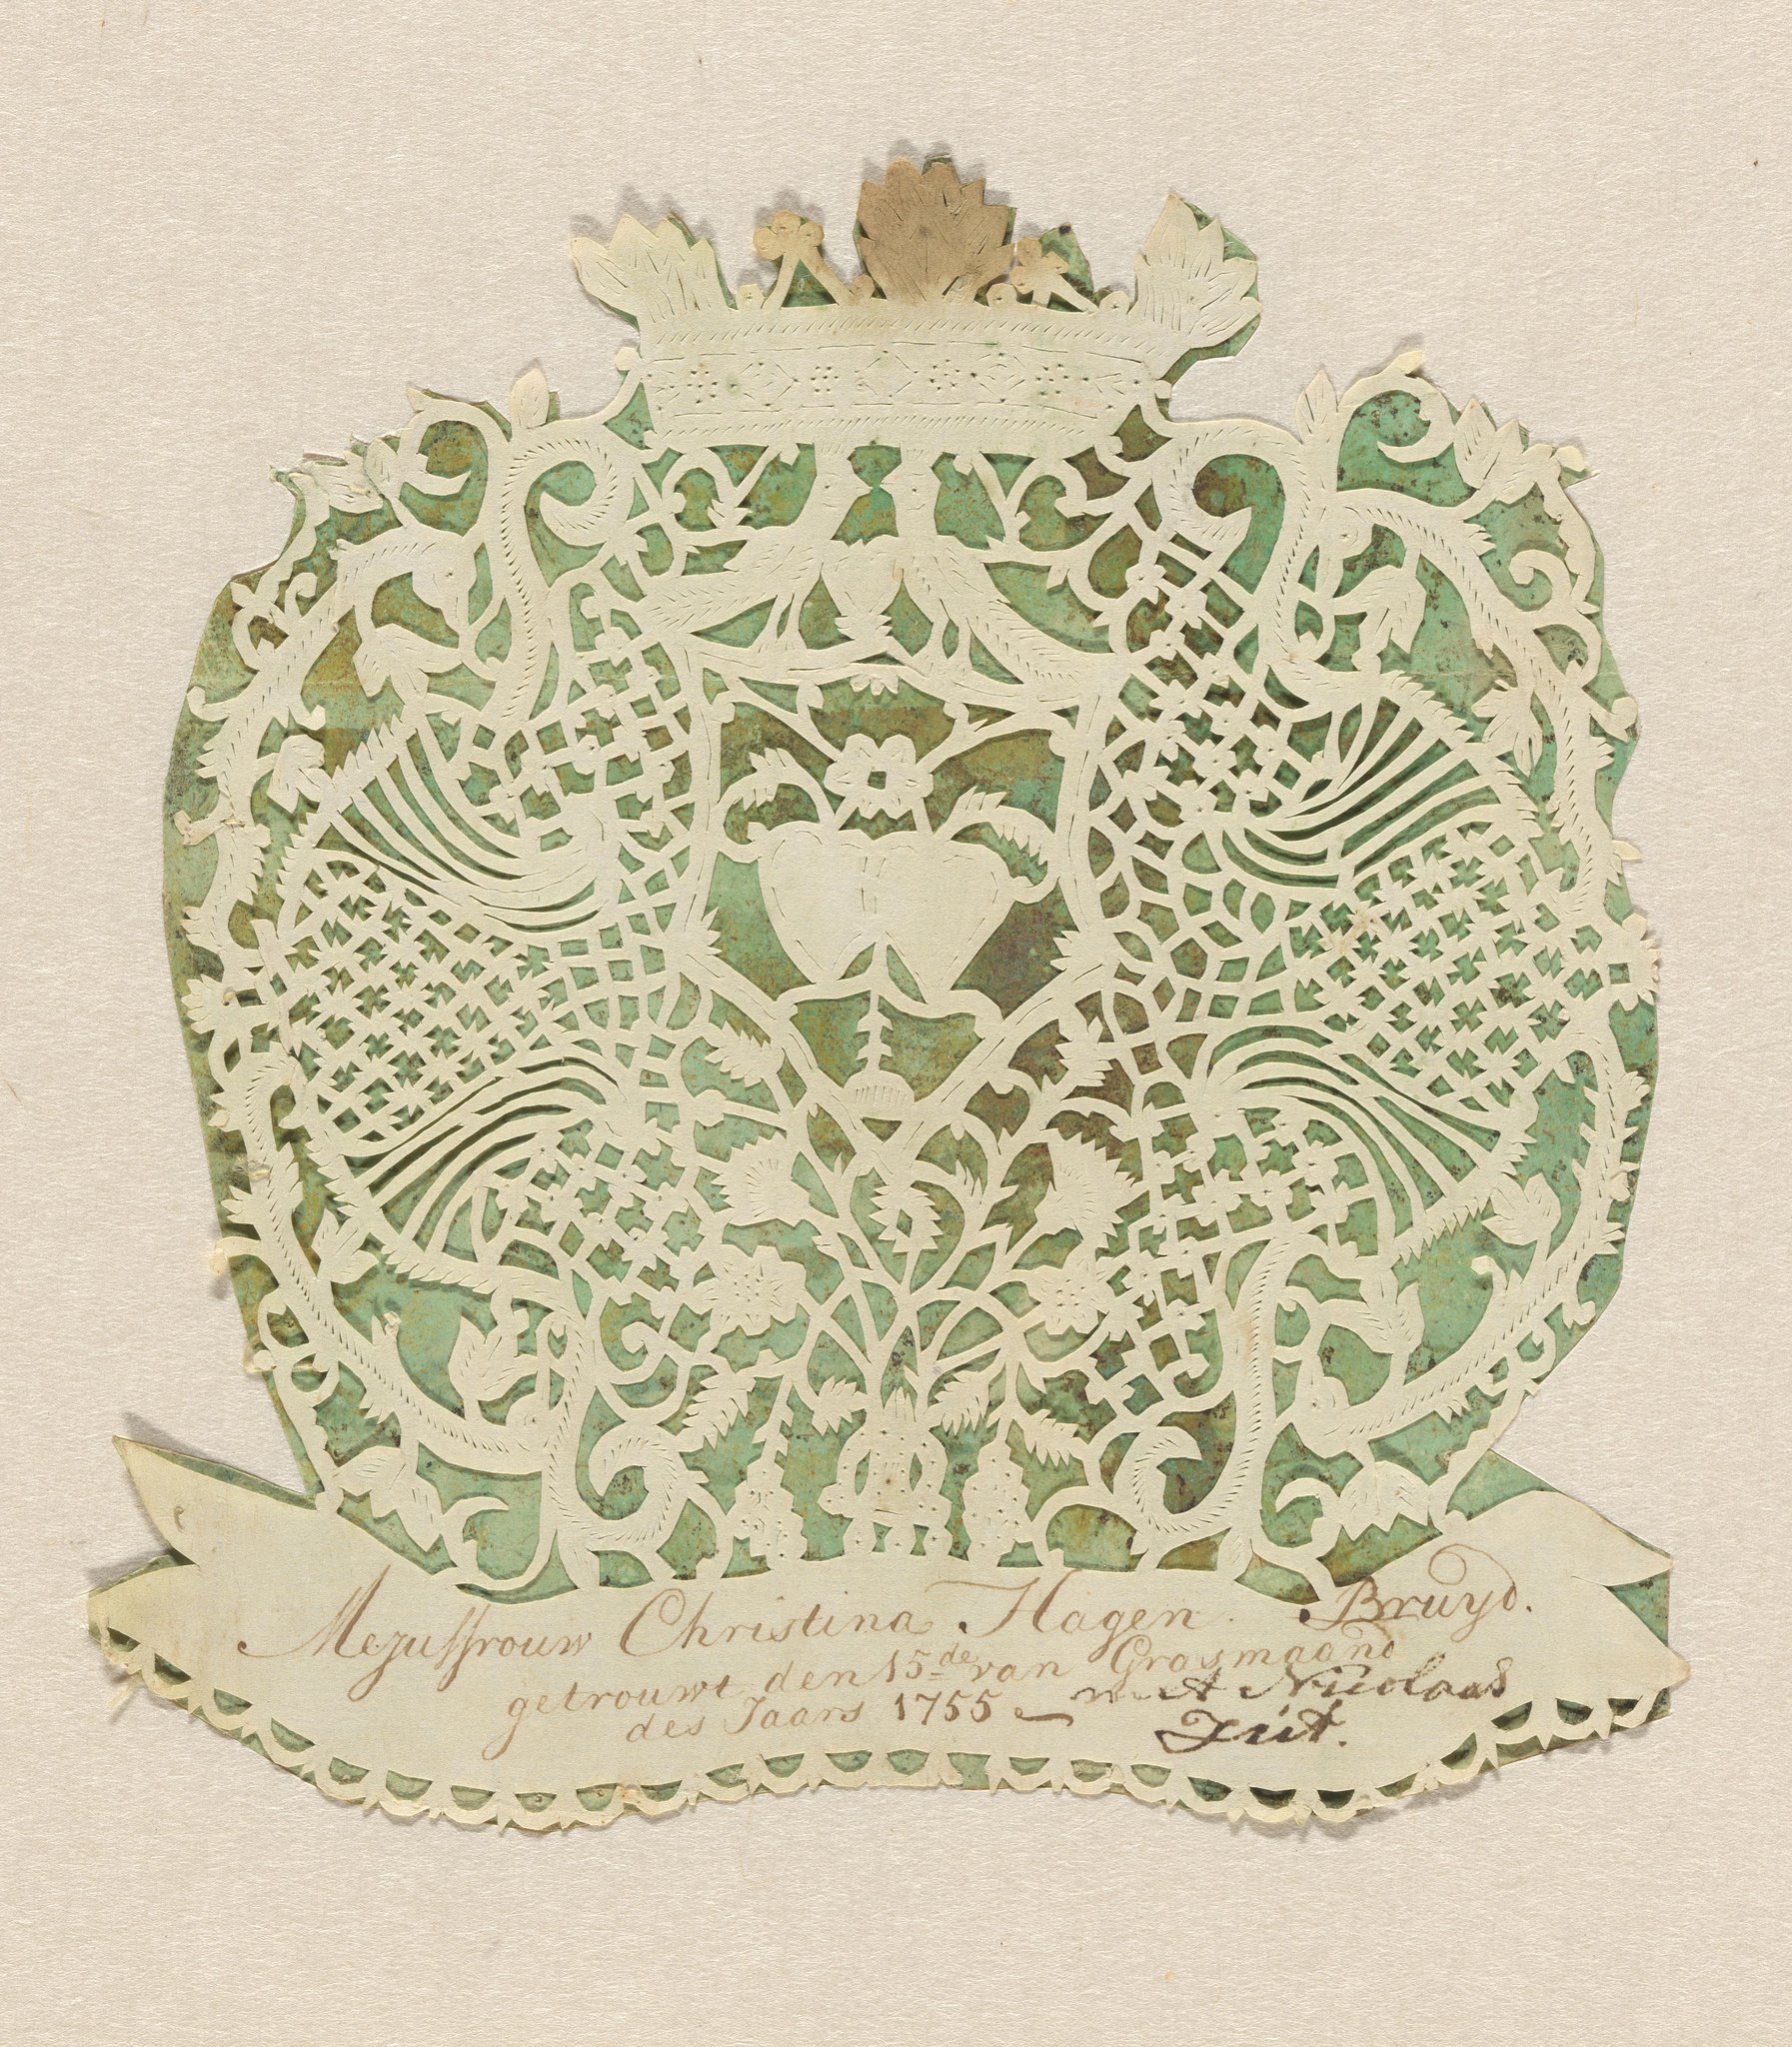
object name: cut paper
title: Huwelijksknipsel voor bruid Christina Hagen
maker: Anonymous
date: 1755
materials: paper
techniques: cutting, snipping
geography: netherlands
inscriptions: inscription: ‘ Mejuffrouw Christina Hagen Bruyd. getrouwd den 15de van Grasmaand des Jaars 1755 - met Nicolas Jut. ’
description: Huwelijksknipsel voor bruid Christina Hagen. Ornament met kroon en harten.